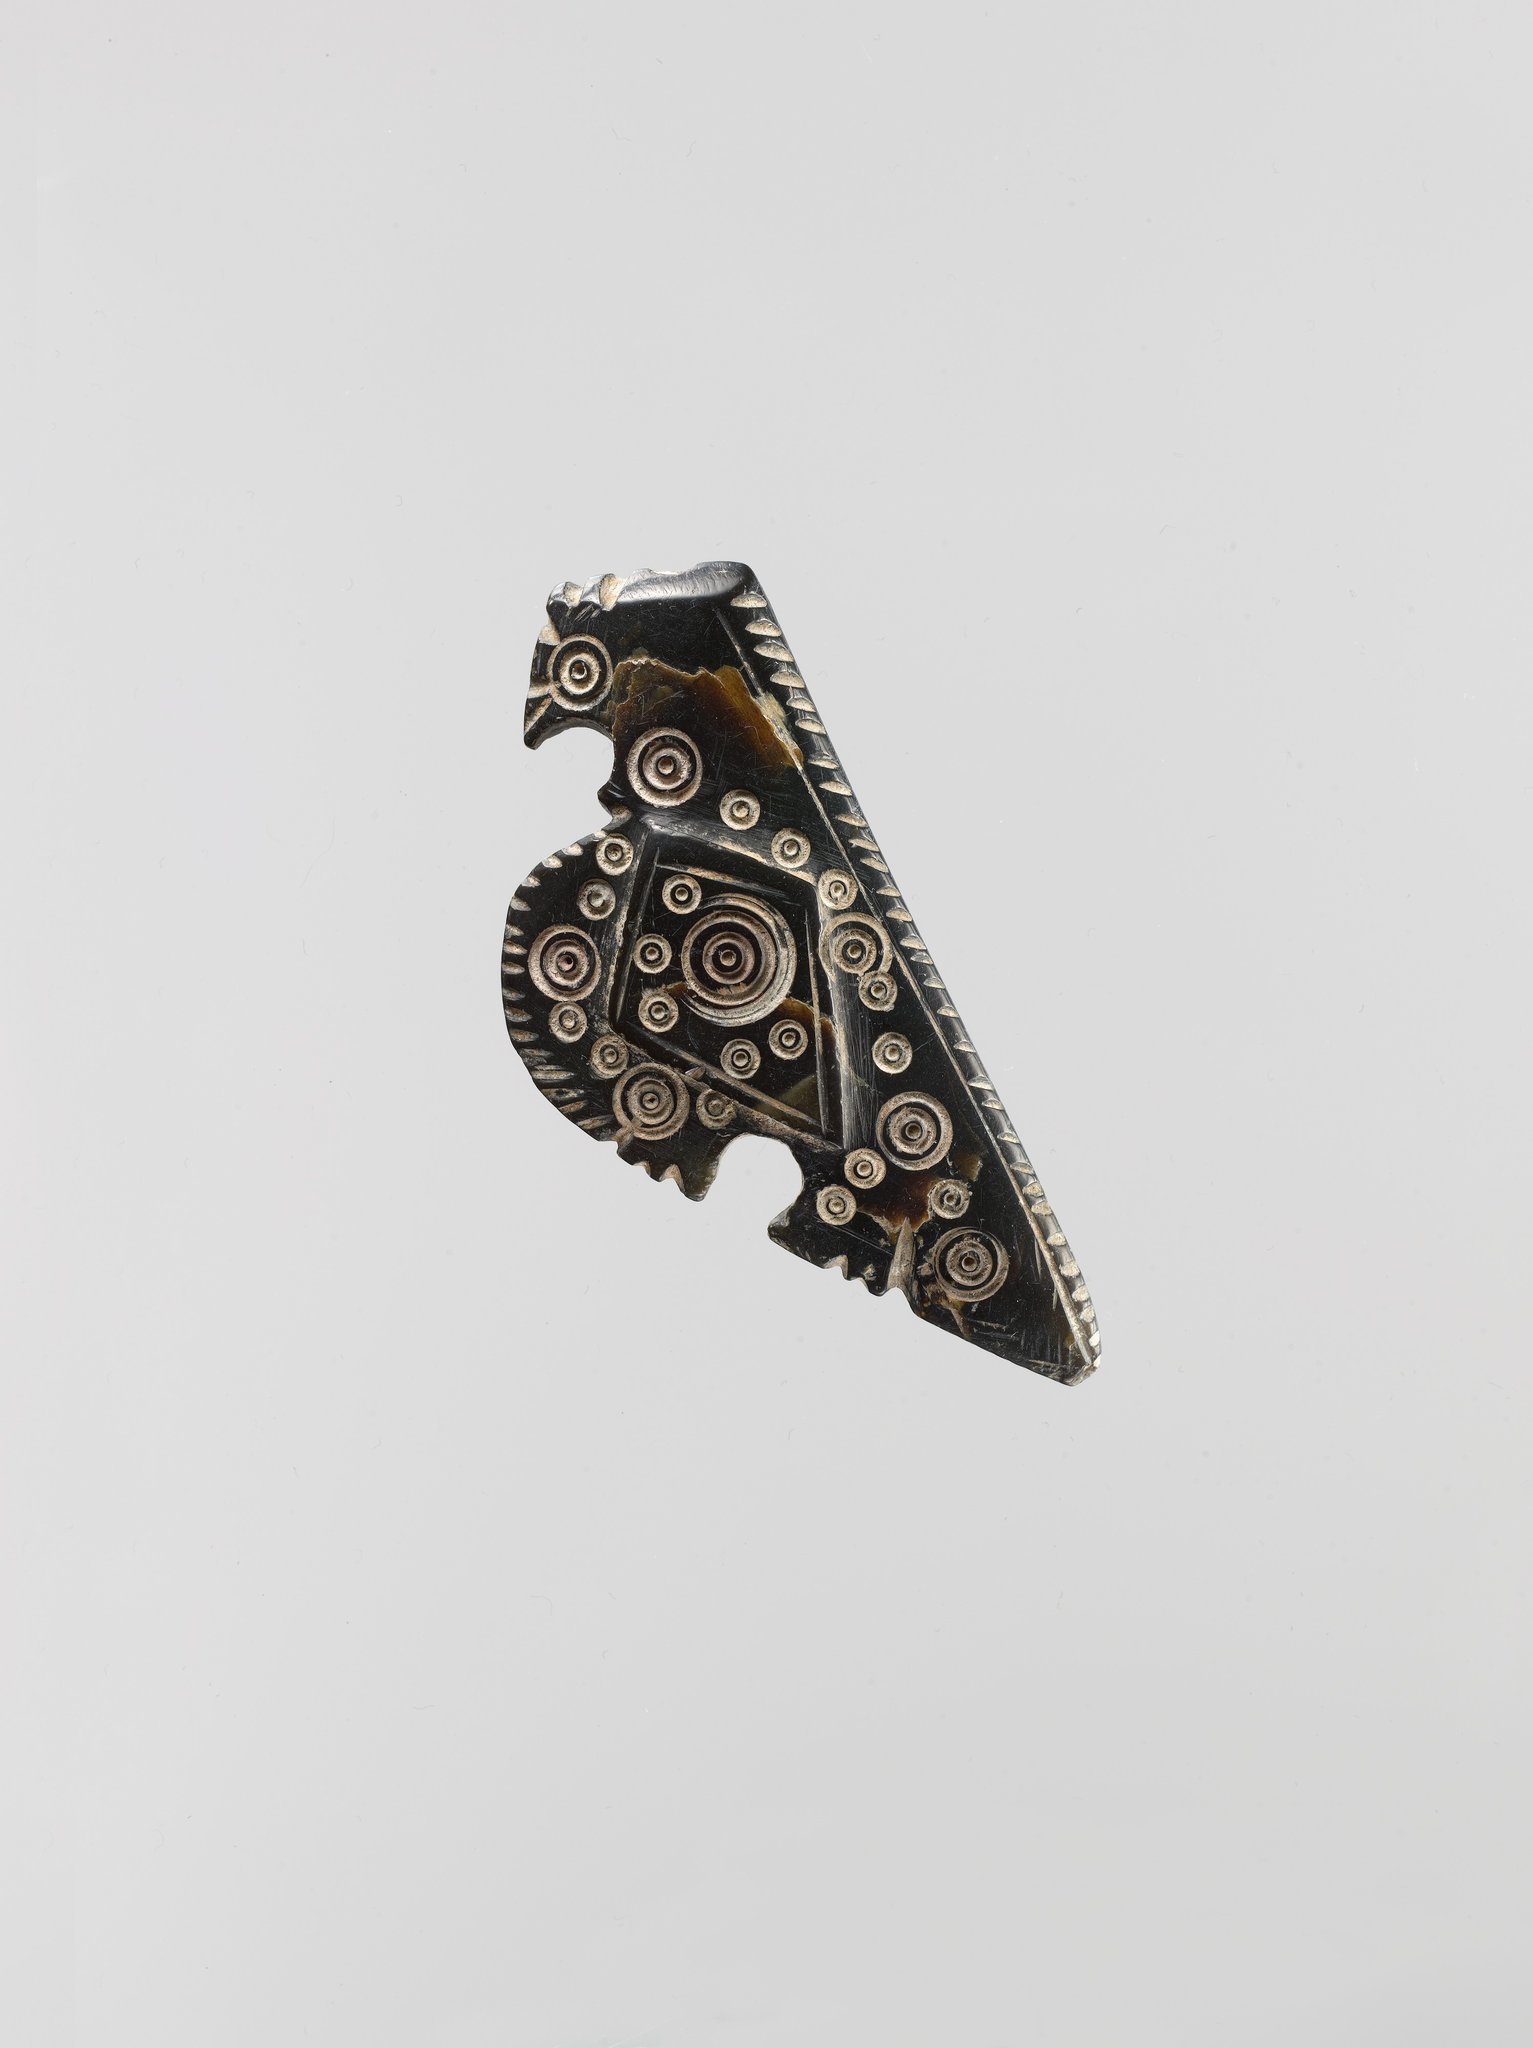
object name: kohl flask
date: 901-1200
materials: stone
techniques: carving, incising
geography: iran